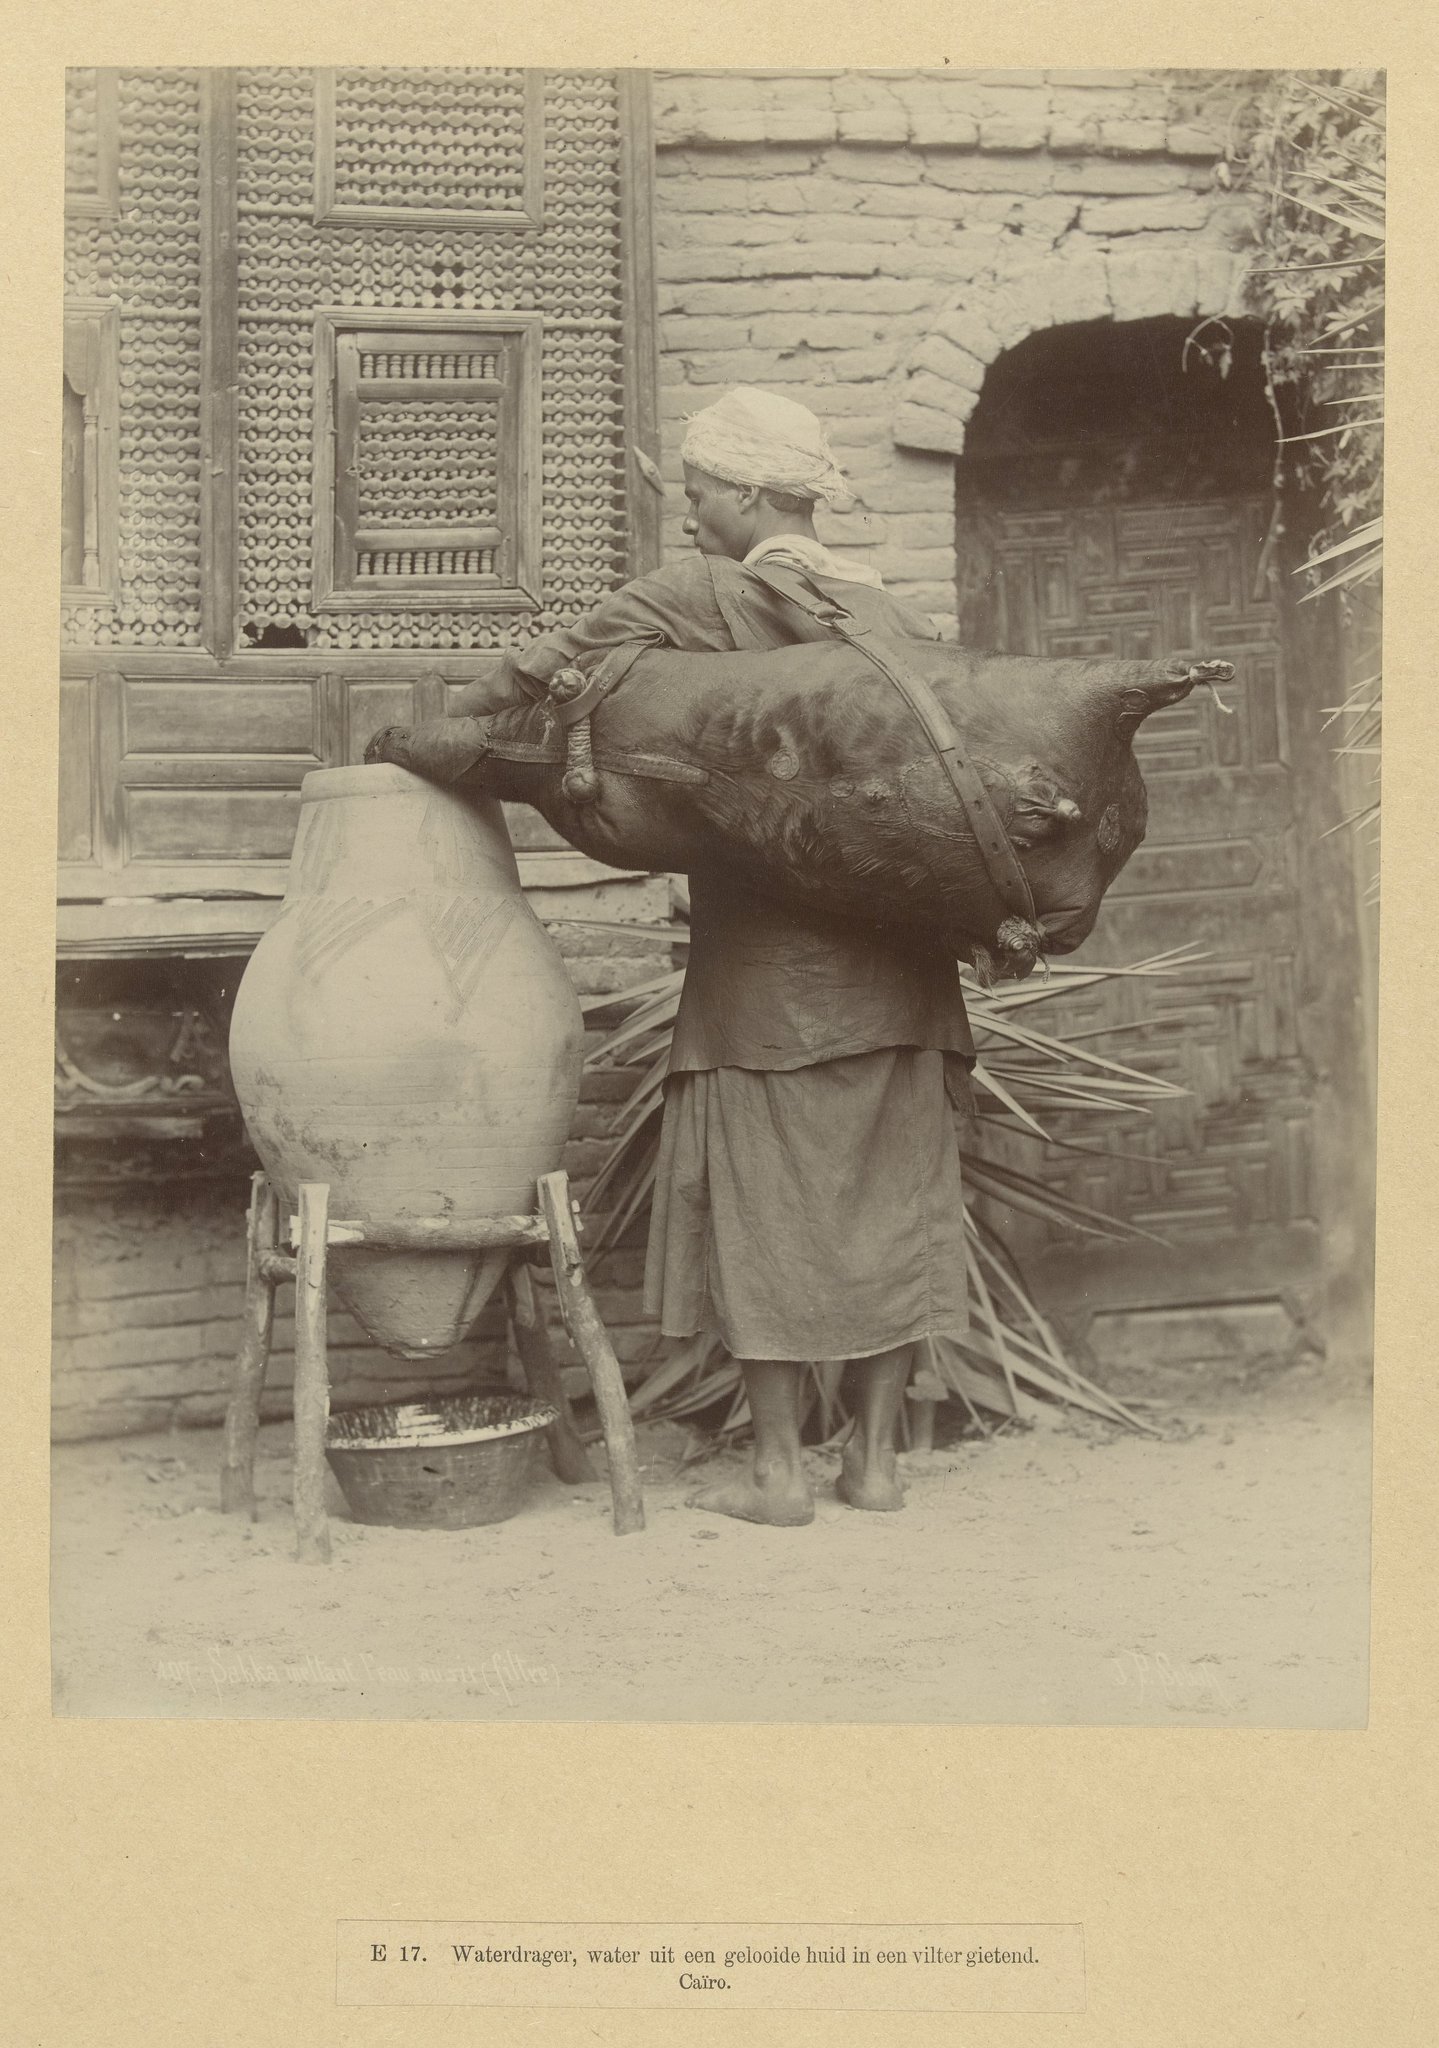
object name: photograph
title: Sakka mettant l'eau au sir (filtre)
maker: jean pascal sébah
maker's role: fotograaf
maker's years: 1872-1947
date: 1888-1895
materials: cardboard, paper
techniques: albumen print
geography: cairo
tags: container of ceramics: jar, jug, pot, vase, container of leather: leather bag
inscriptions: title: ‘E 17. Waterdrager, water uit een gelooide huid in een vilter gietend./ Caïro’, check stamp: ‘Bristol/ L.M.’, number: ‘407’, stamp: ‘Gemeentelijke bibliotheek/ Rotterdam’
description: Onderdeel van een groep door fotograaf Richard Polak op reis verzamelde foto’s. Deze foto is samen met andere op zijn reizen verzamelde foto's tentoongesteld bij de Rotterdamsche Kunstkring (1895), Arti en Amicitiae te Amsterdam (1897-1898?) en Societeit 't Collegie te Kampen (datum vooralsnog onbekend).